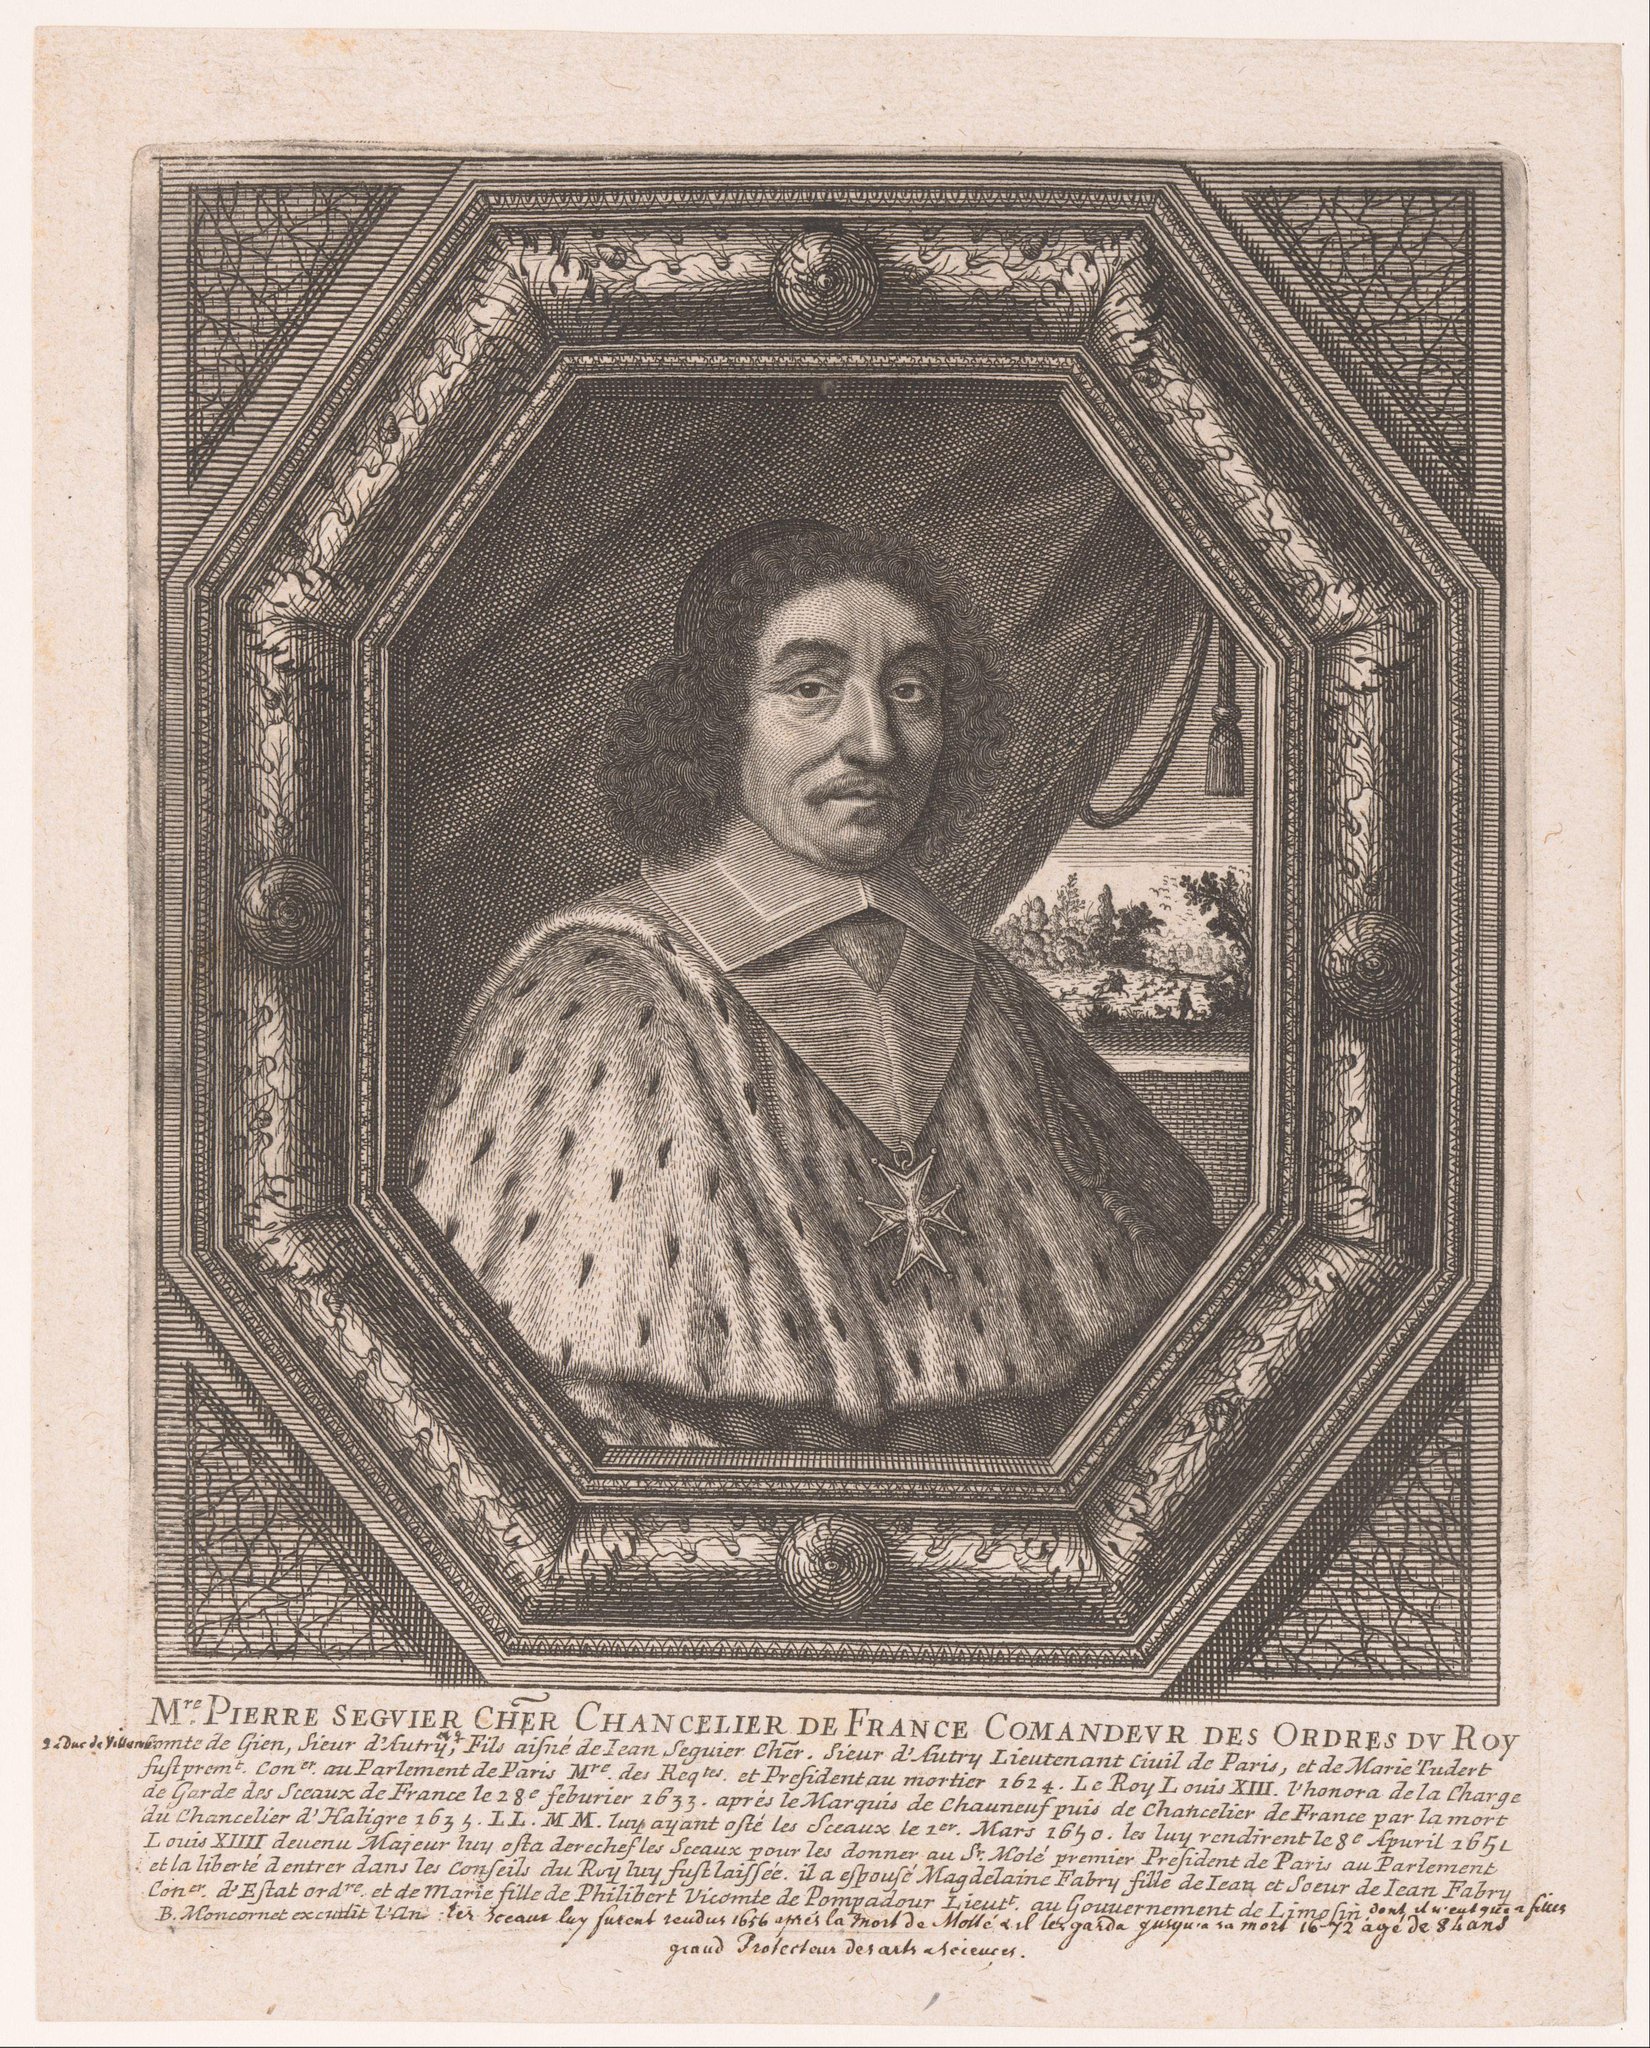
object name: print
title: Portret van Pierre Séguier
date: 1651-1668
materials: paper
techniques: engraving, etching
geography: paris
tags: paris, pierre séguier, historical persons, politician, e.g. party leader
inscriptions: collector's mark: Lugt 2228